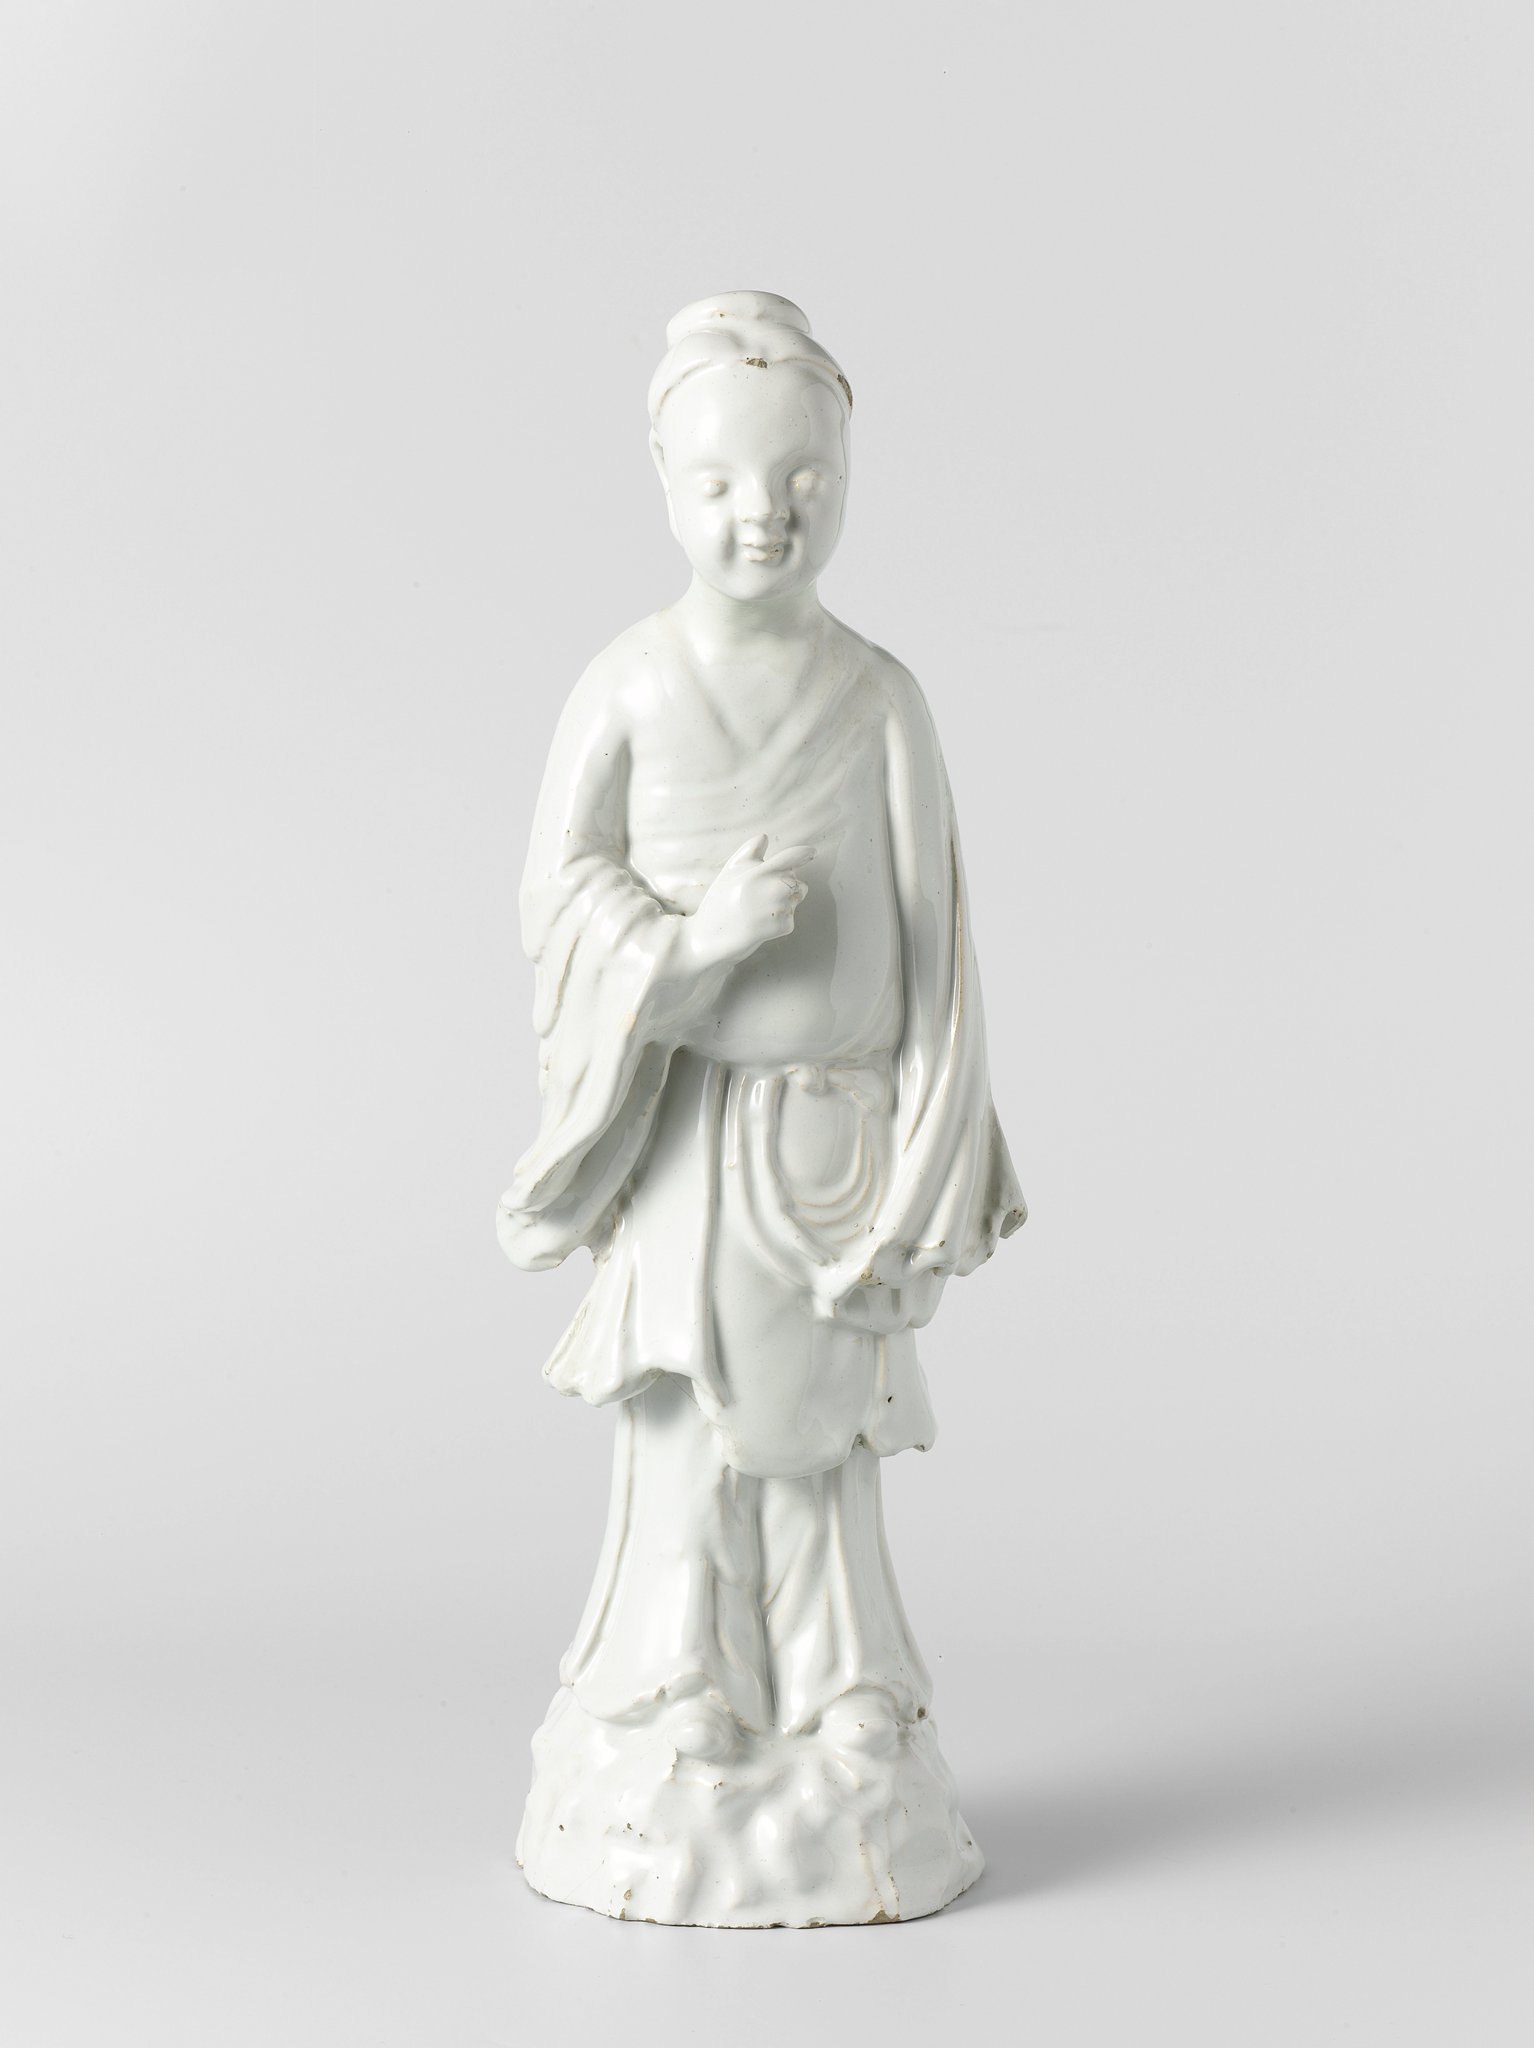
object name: vrouwenfiguur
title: Chinese vrouwenfiguur, faience, ongedecoreerd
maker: Anonymous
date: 1720-1770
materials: faience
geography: delft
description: Vrouwenfiguur van faience, voorstellende een Chinese vrouw. Wit geglazuurd.